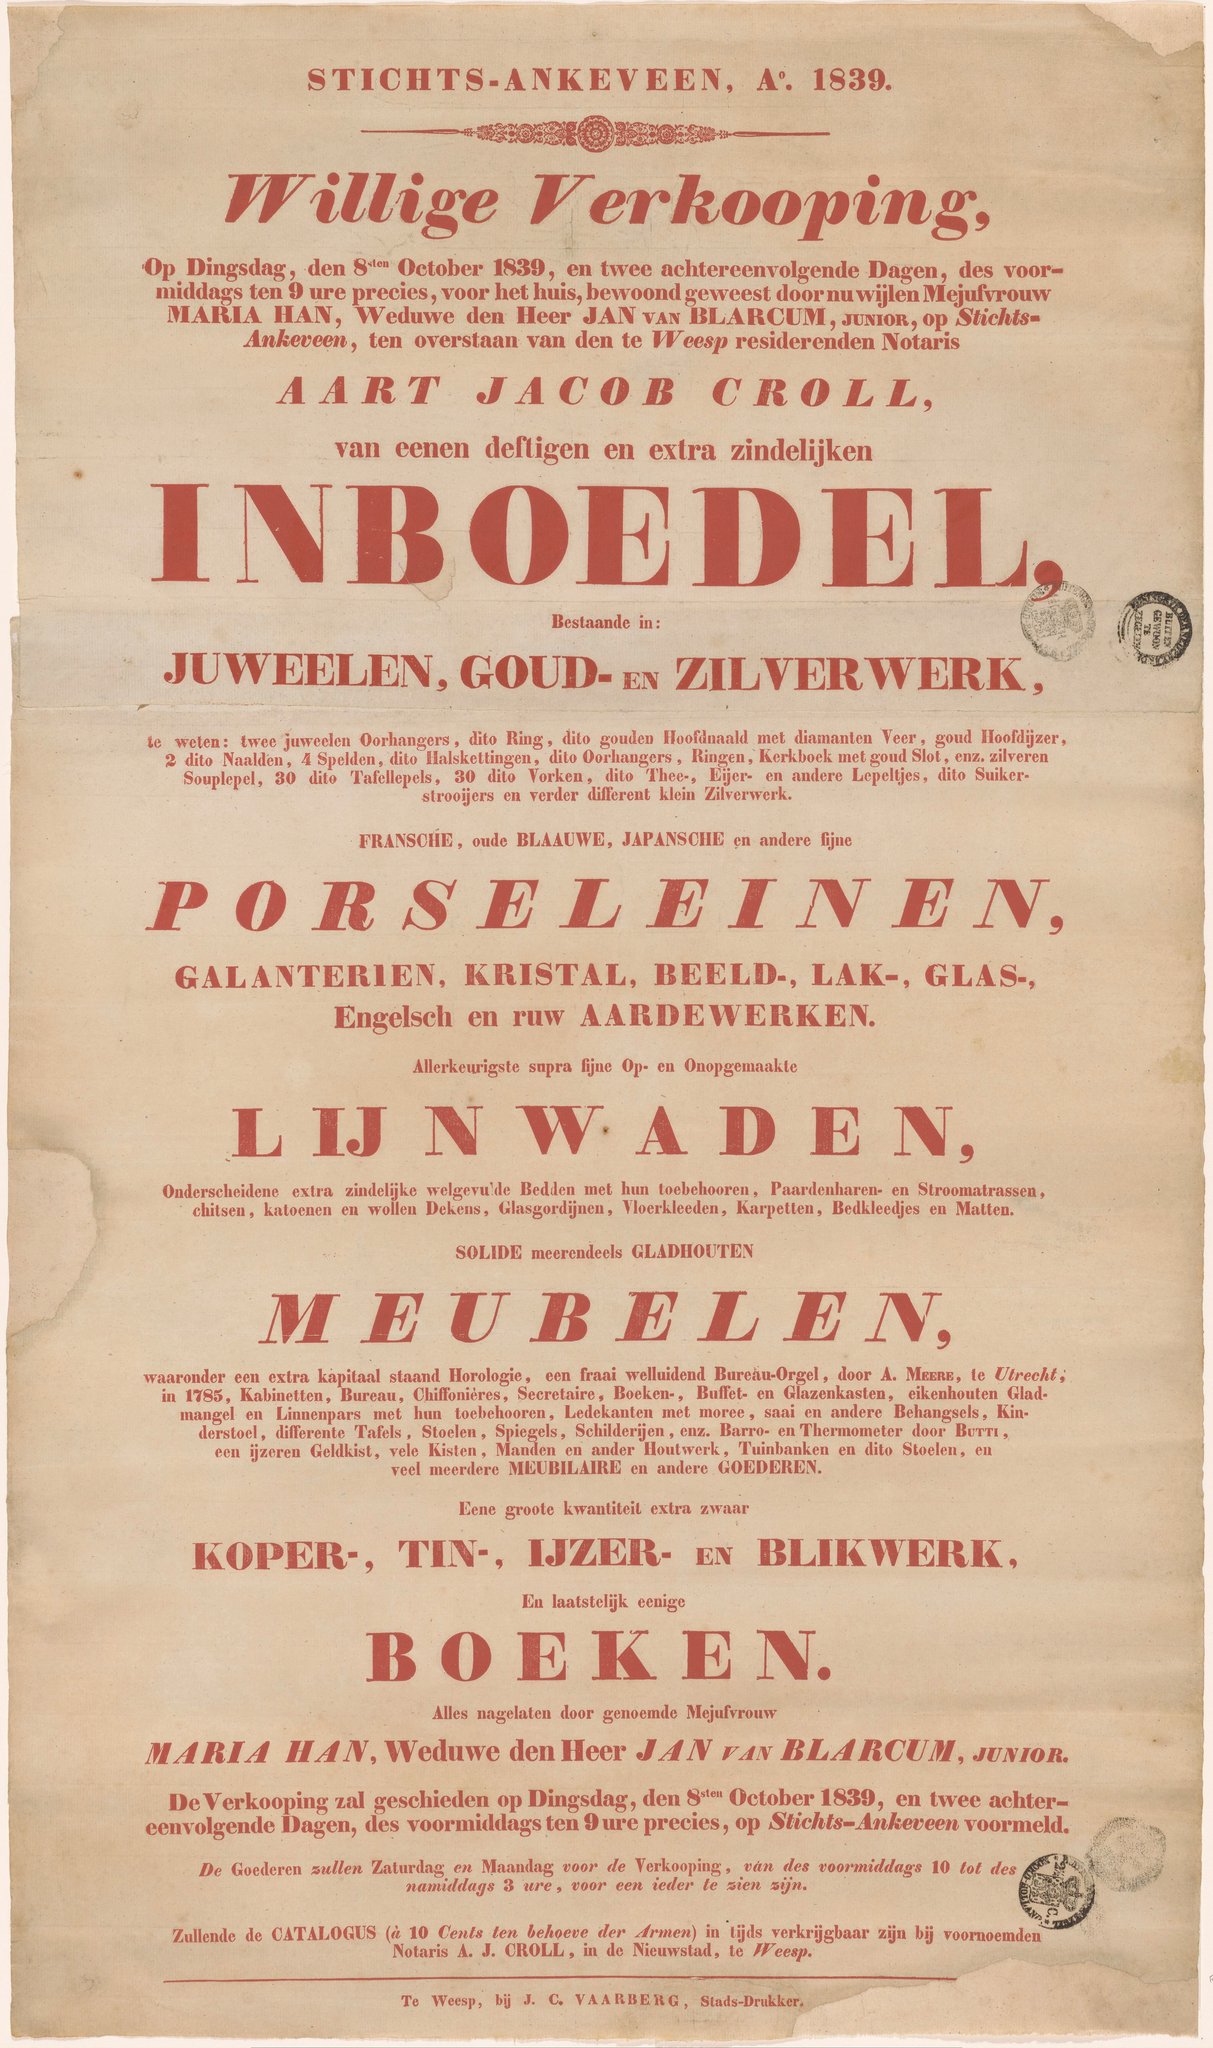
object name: poster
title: Aankondiging van een inboedelveiling te Ankeveen, 1839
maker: jan christoffel vaarberg vaarberg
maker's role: printer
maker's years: 1797-1851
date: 1810-1839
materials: paper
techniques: letterpress printing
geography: weesp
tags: ankeveen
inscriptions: stamp: ‘Koninkrijk der Nederlanden / buiten gewoon te zegelen’, collector's mark: Lugt 2228, stamp: ‘Buitengewoon Zegel Noord-Holland / 2 1/2 C.’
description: Aankondiging van de veiling van de inboedel van Maria Han, weduwe van Jan van Blarcum junior, op 8 oktober 1839 en de twee daarop volgende dagen.